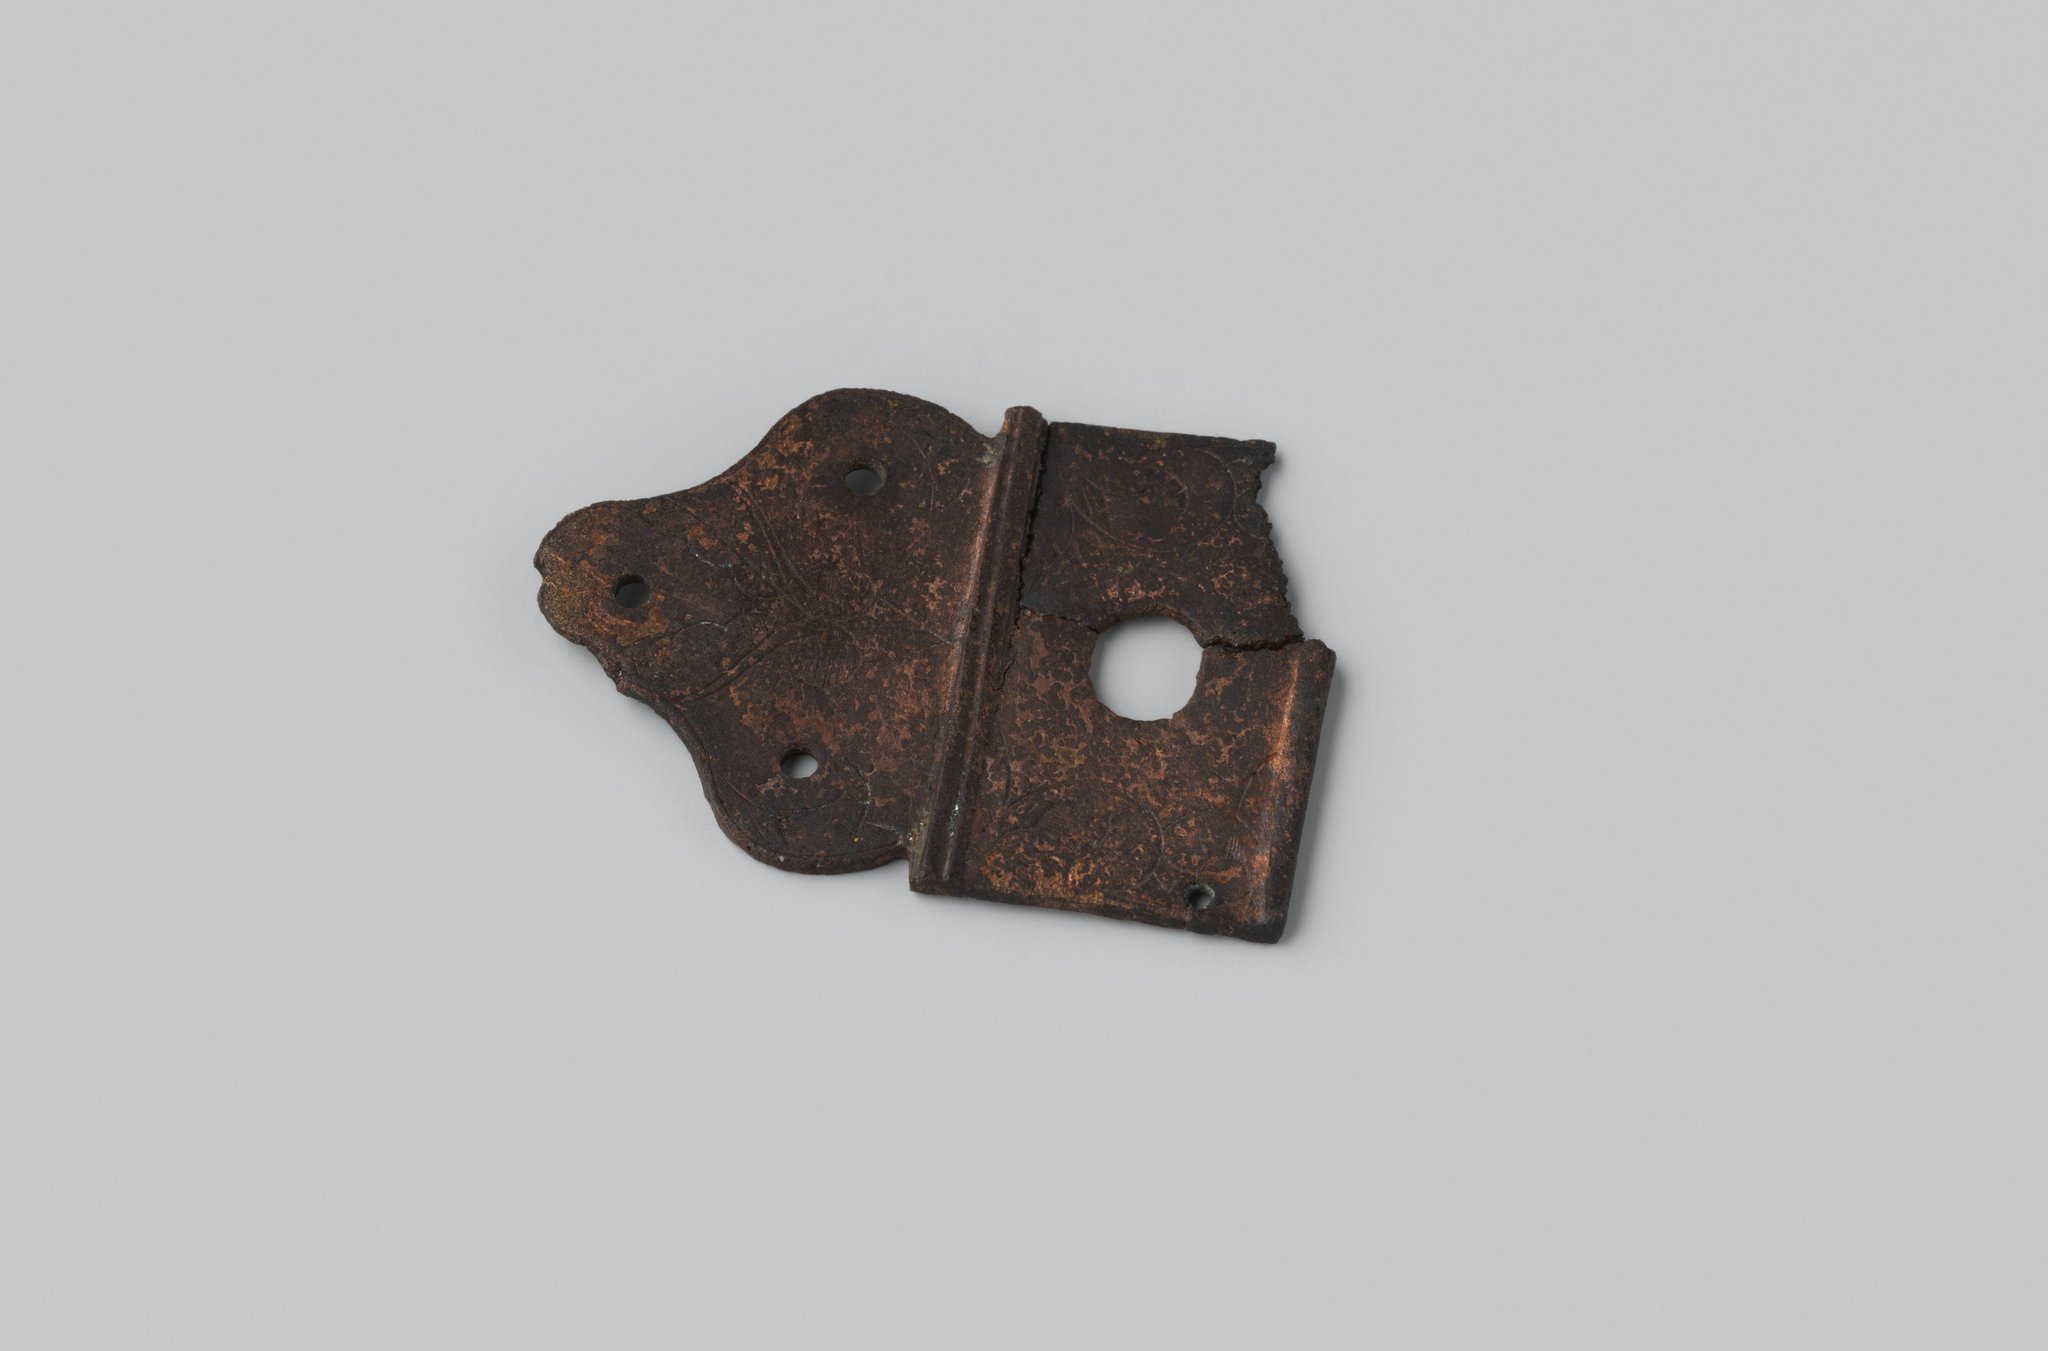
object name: lock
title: Deel van een slot uit het wrak van de Oost-Indiëvaarder Hollandia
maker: Anonymous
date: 1700-1743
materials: copper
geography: netherlands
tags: verenigde oostindische compagnie, hollandia (schip), annet